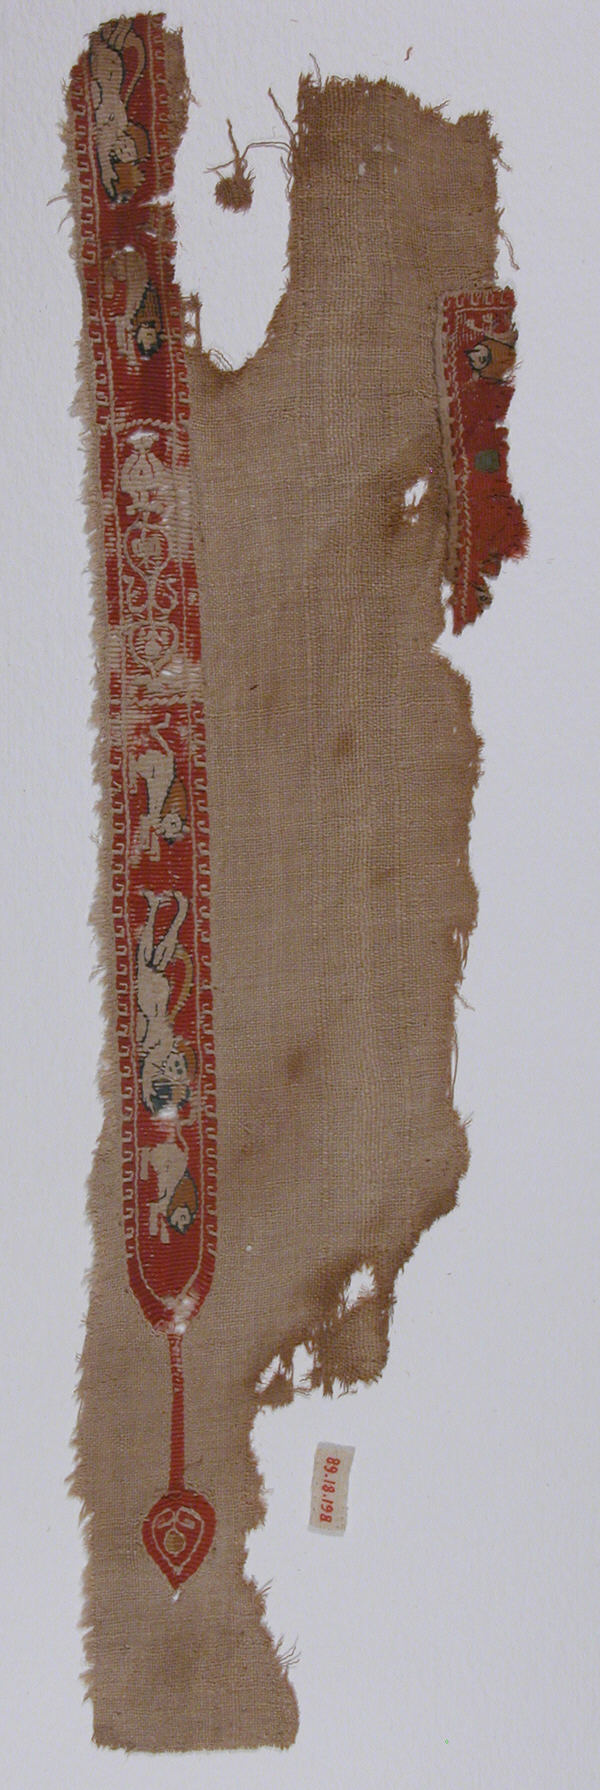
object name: textile fragment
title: Tunic Fragment with Lions and Putti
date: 401-700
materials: linen, wool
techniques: weave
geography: egypt